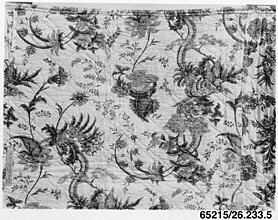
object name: floral print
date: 1785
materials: cotton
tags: flowers,leaves